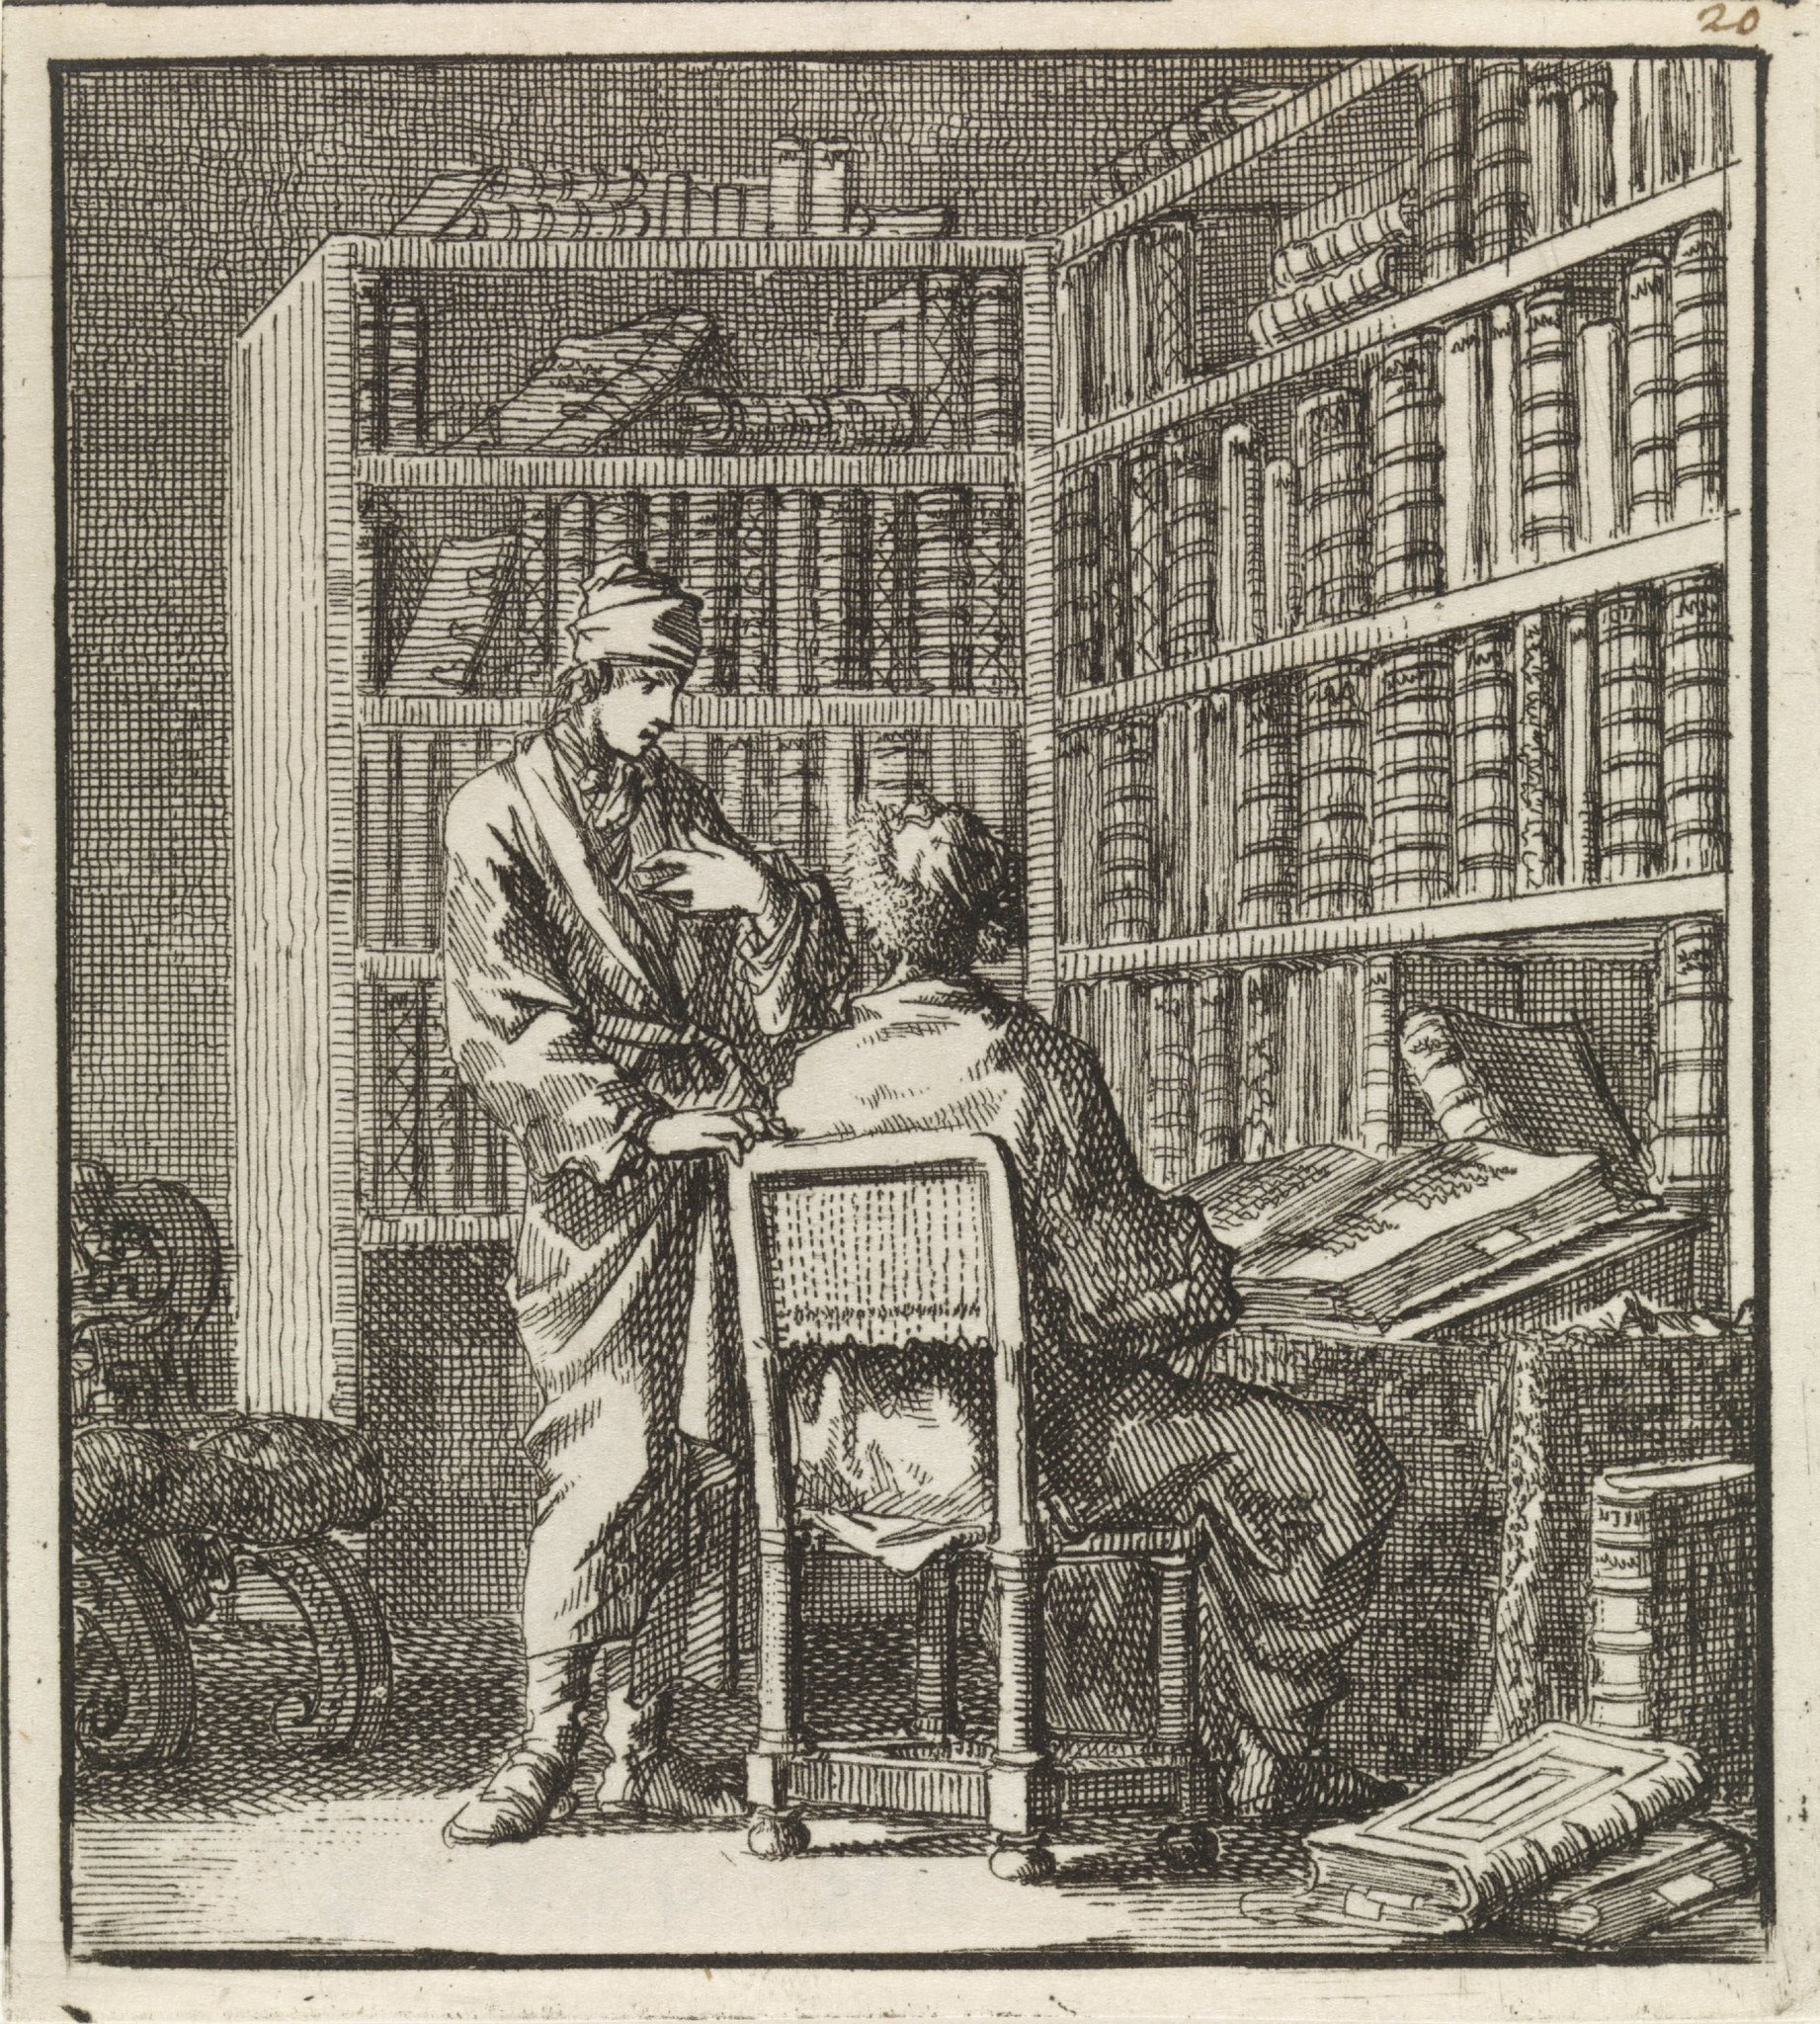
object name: print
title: De Boeke-kas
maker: jan luyken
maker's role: draughtsman, print maker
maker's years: 1649-1712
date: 1711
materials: paper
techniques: etching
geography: amsterdam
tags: reading, book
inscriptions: collector's mark: Lugt 2228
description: Proefdruk van illustratie voor: Luyken, Jan. Het leerzaam huisraad, vertoond in vyftig konstige figuuren, met godlyke spreuken en stichtelyke verzen: Pieter Arentsz. II (wed.) en Cornelis van der Sys, 1711, p. 72.